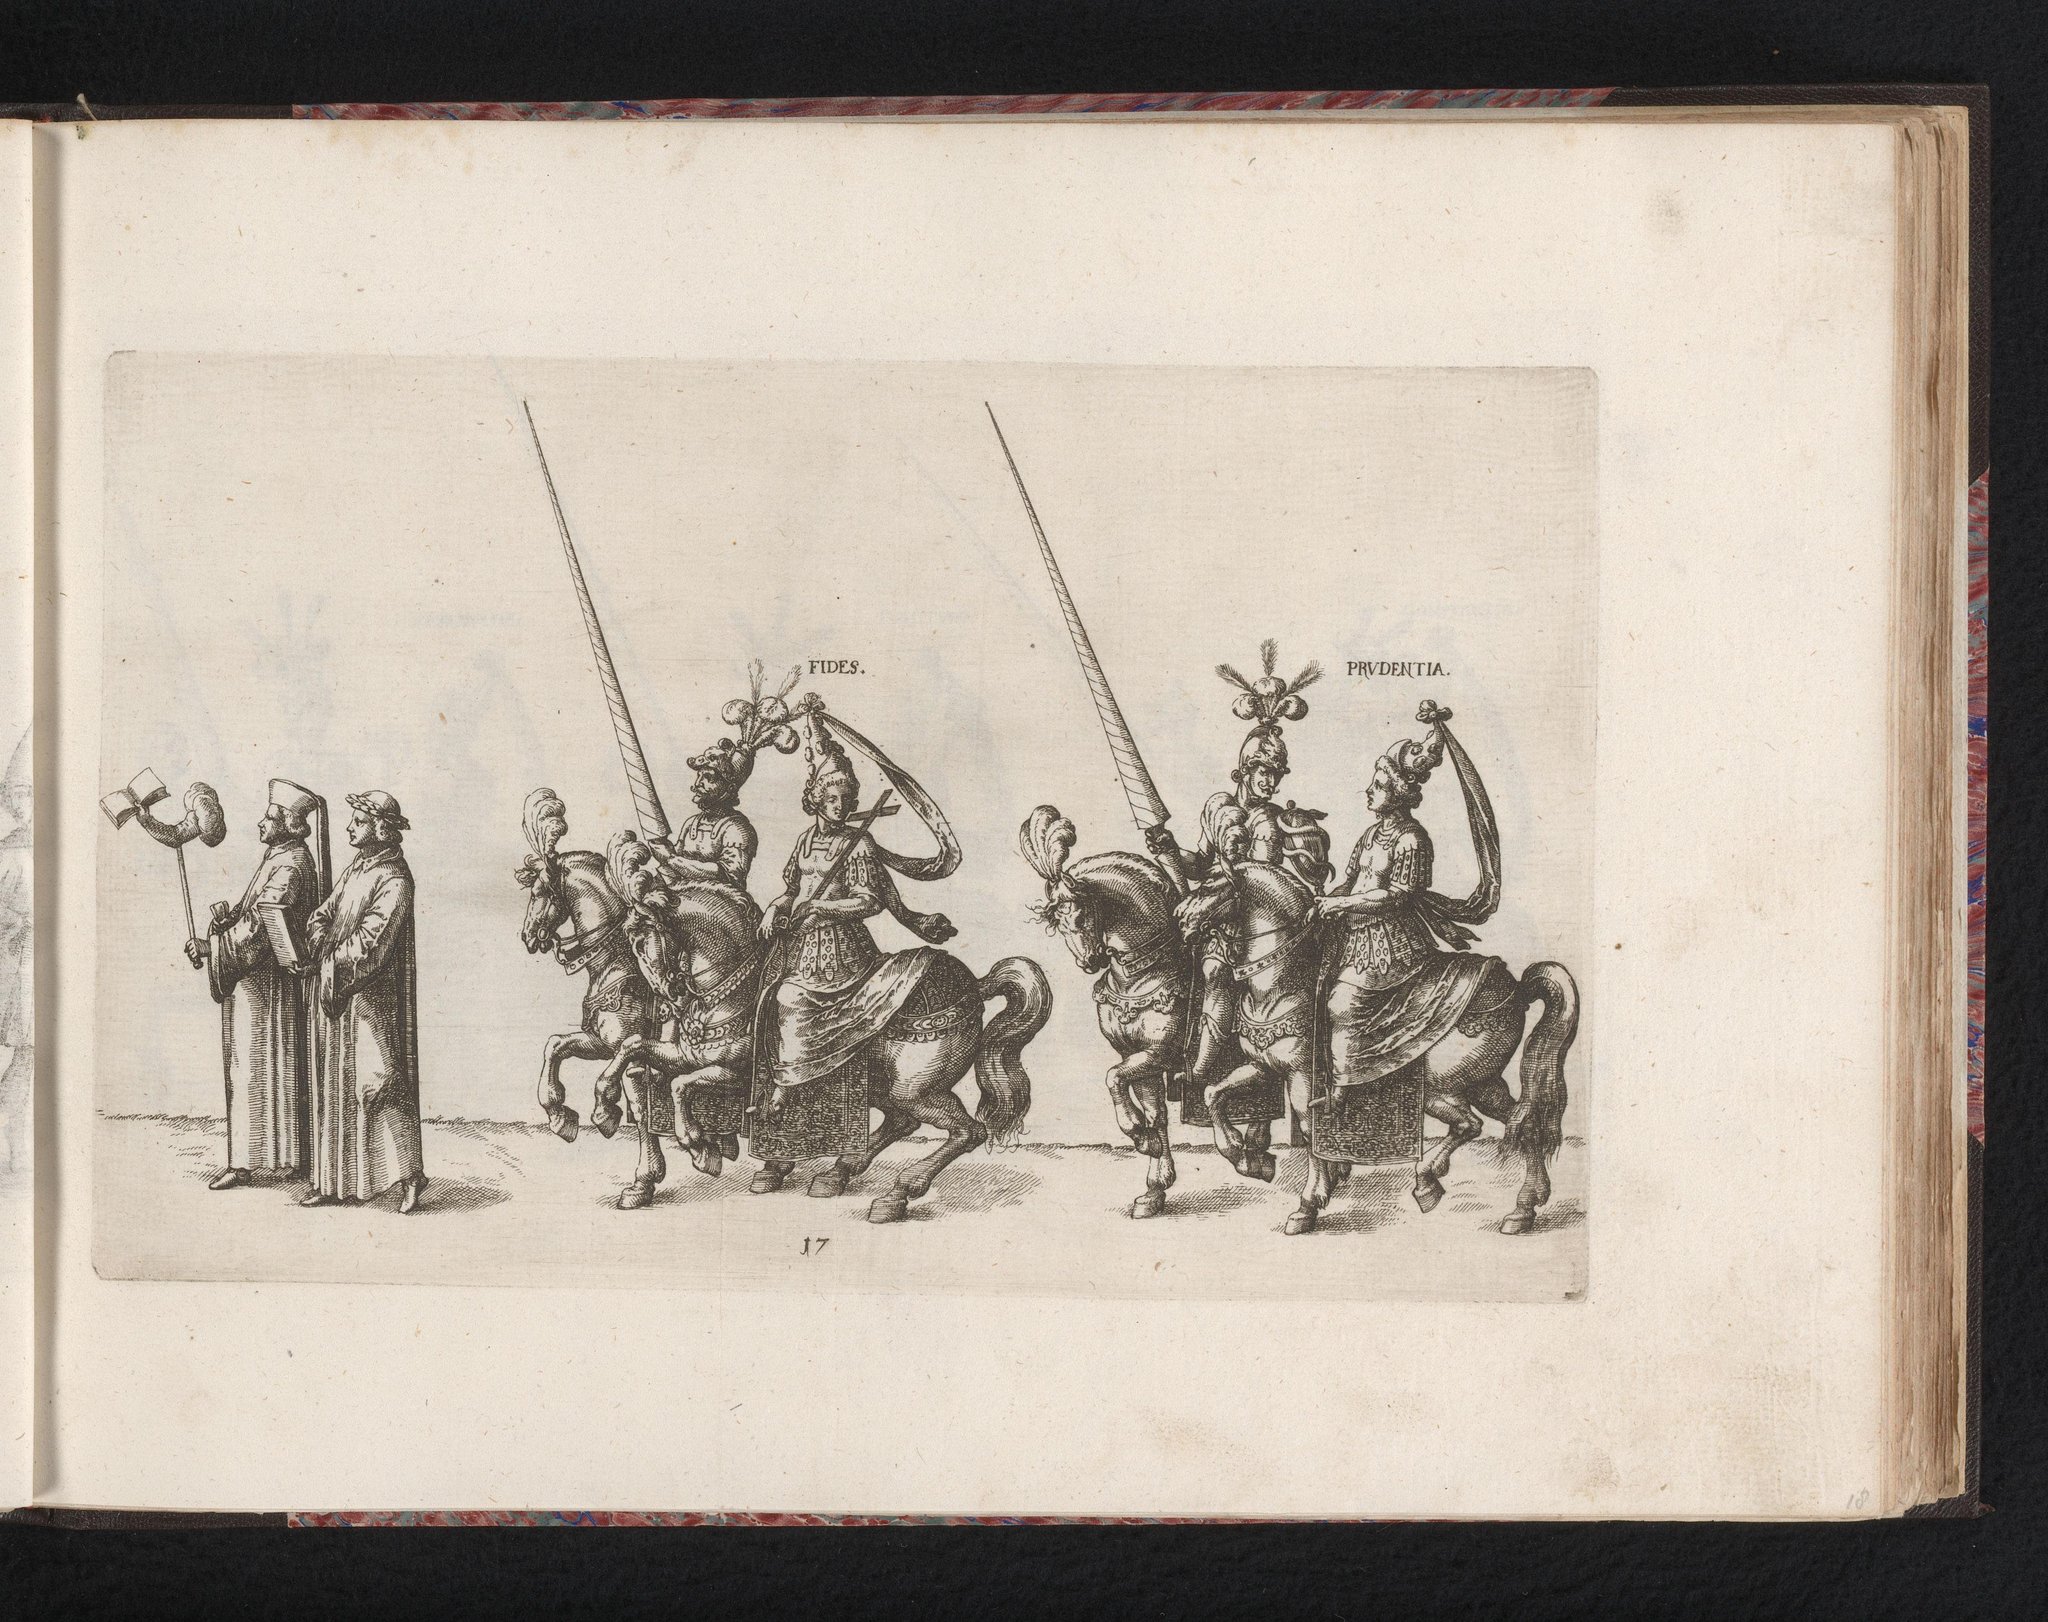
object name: album leaf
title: Optochten en ruiterspelen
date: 1618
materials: paper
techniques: etching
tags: musical instruments; group of musical instruments - cc - out of doors, garden fountain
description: Genummerd: 16. Deze prent maakt deel uit van een album.